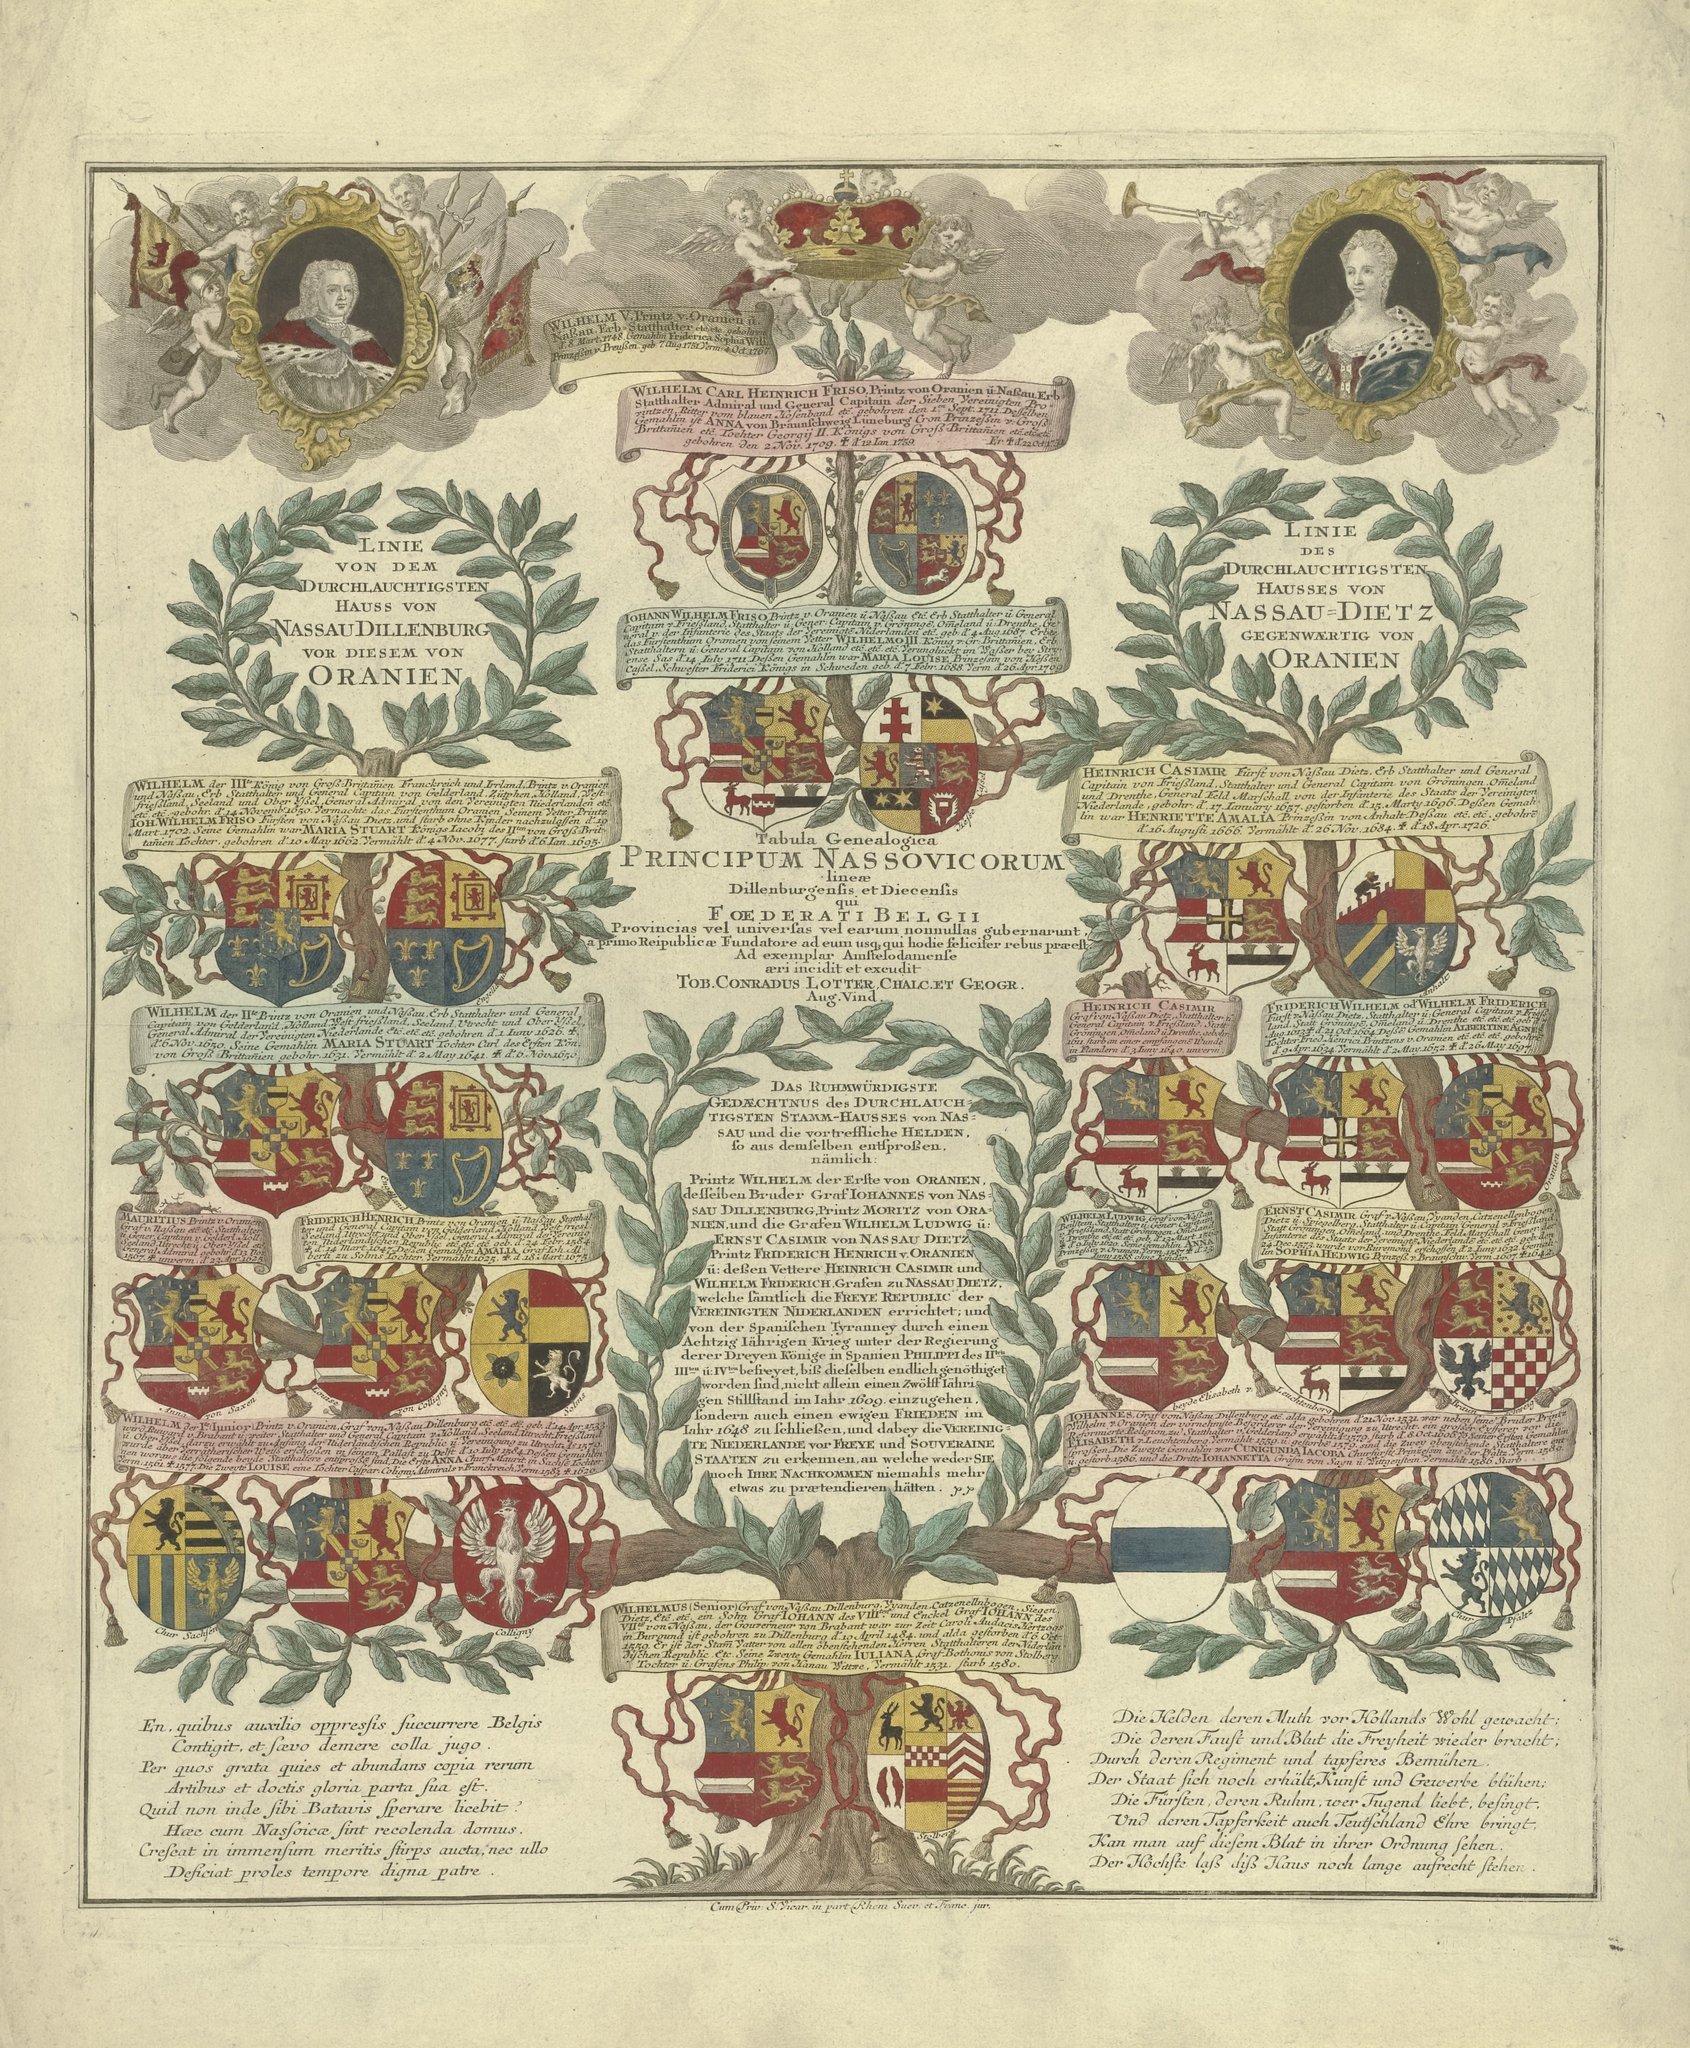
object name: print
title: Stamboom van het Huis Oranje-Nassau, 1767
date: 1767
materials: paper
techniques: engraving, etching, hand coloring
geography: augsburg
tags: the hague, william v (prince of orange), berlin, painter, draughtsman, wilhelmina of prussia (princess of orange), family lineage, pedigree, genealogical tree or table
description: Stamboom van het Huis Oranje-Nassau met de leden van dit huis die in de Nederlanden hebben geregeerd, uitmondend bovenaan bij prins Willem V en zijn echtgenote Wilhelmina van Pruisen. Links de uitgestorven lijn Nassau Dillenburg eindigend bij stadhouder-koning Willem III, rechts de Friese tak Nassau-Dietz met Johan Willem Friso en Willem IV. Centraal een met lauwerbladen omlijste tekst over het huis Oranje-Nassau. Bovenaan portretten van de prins en prinses gedragen door putti. Onderaan verzen in het Latijn en Duits. Waarschijnlijk ter gelegenheid van het huwelijk op 4 oktober 1767.